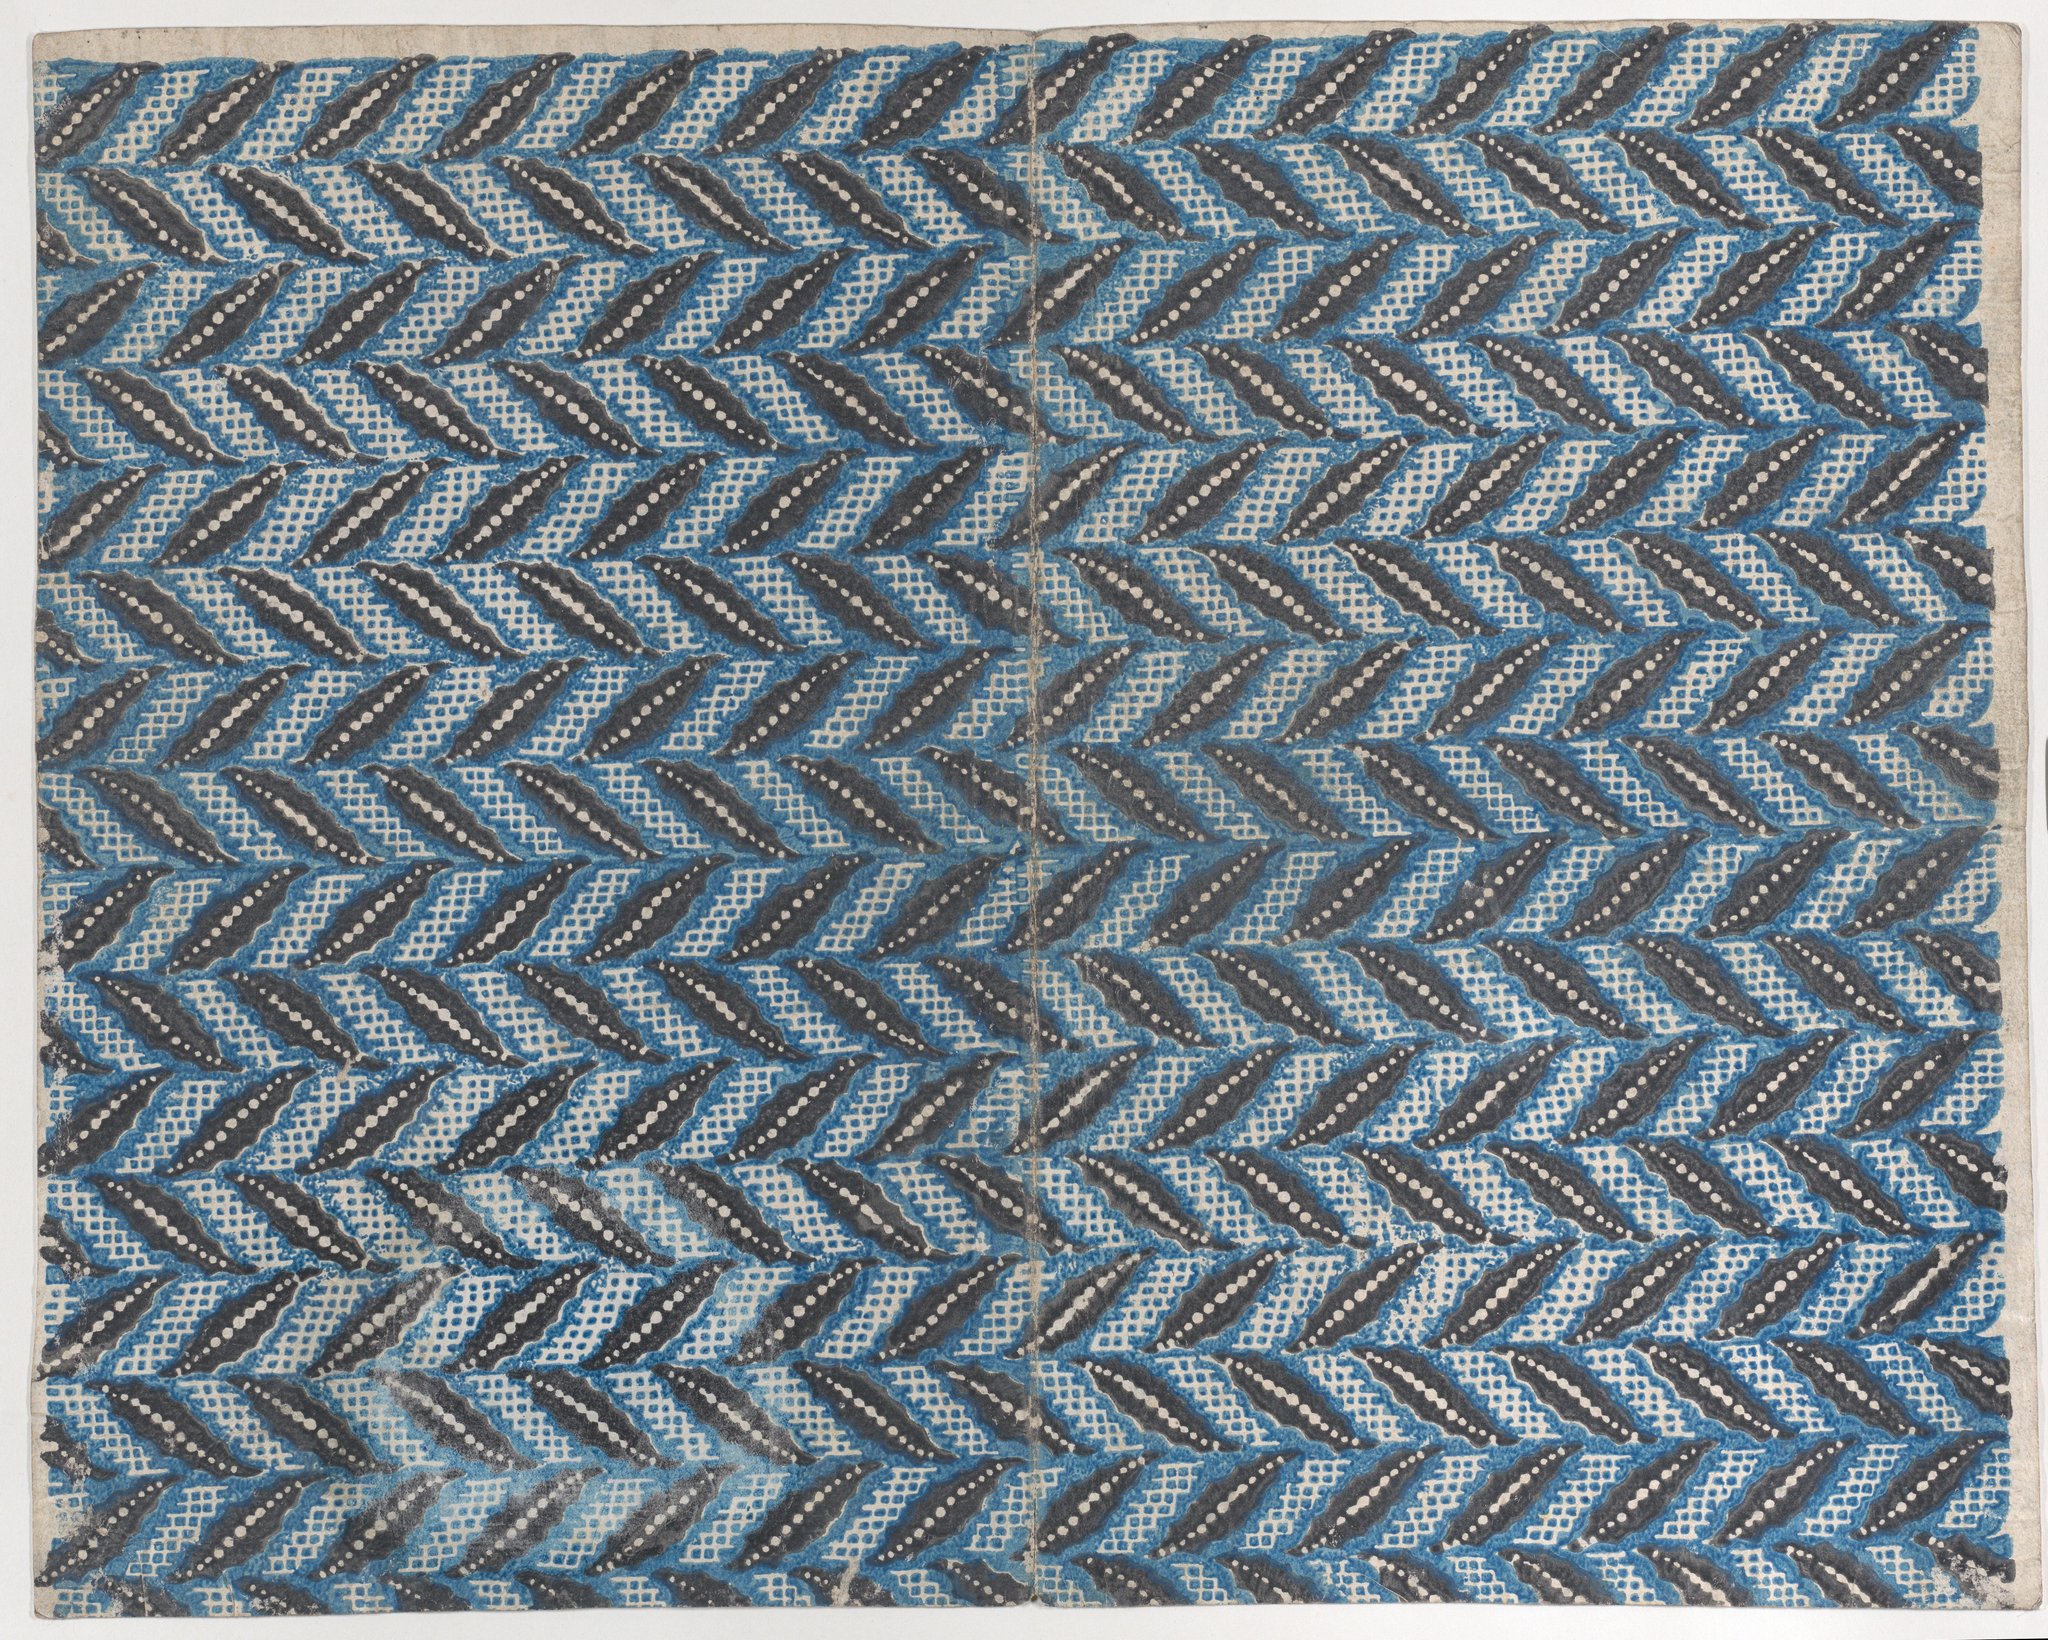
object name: print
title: Book cover with black and blue abstract pattern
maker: Anonymous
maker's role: artist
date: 1801-1900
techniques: relief print